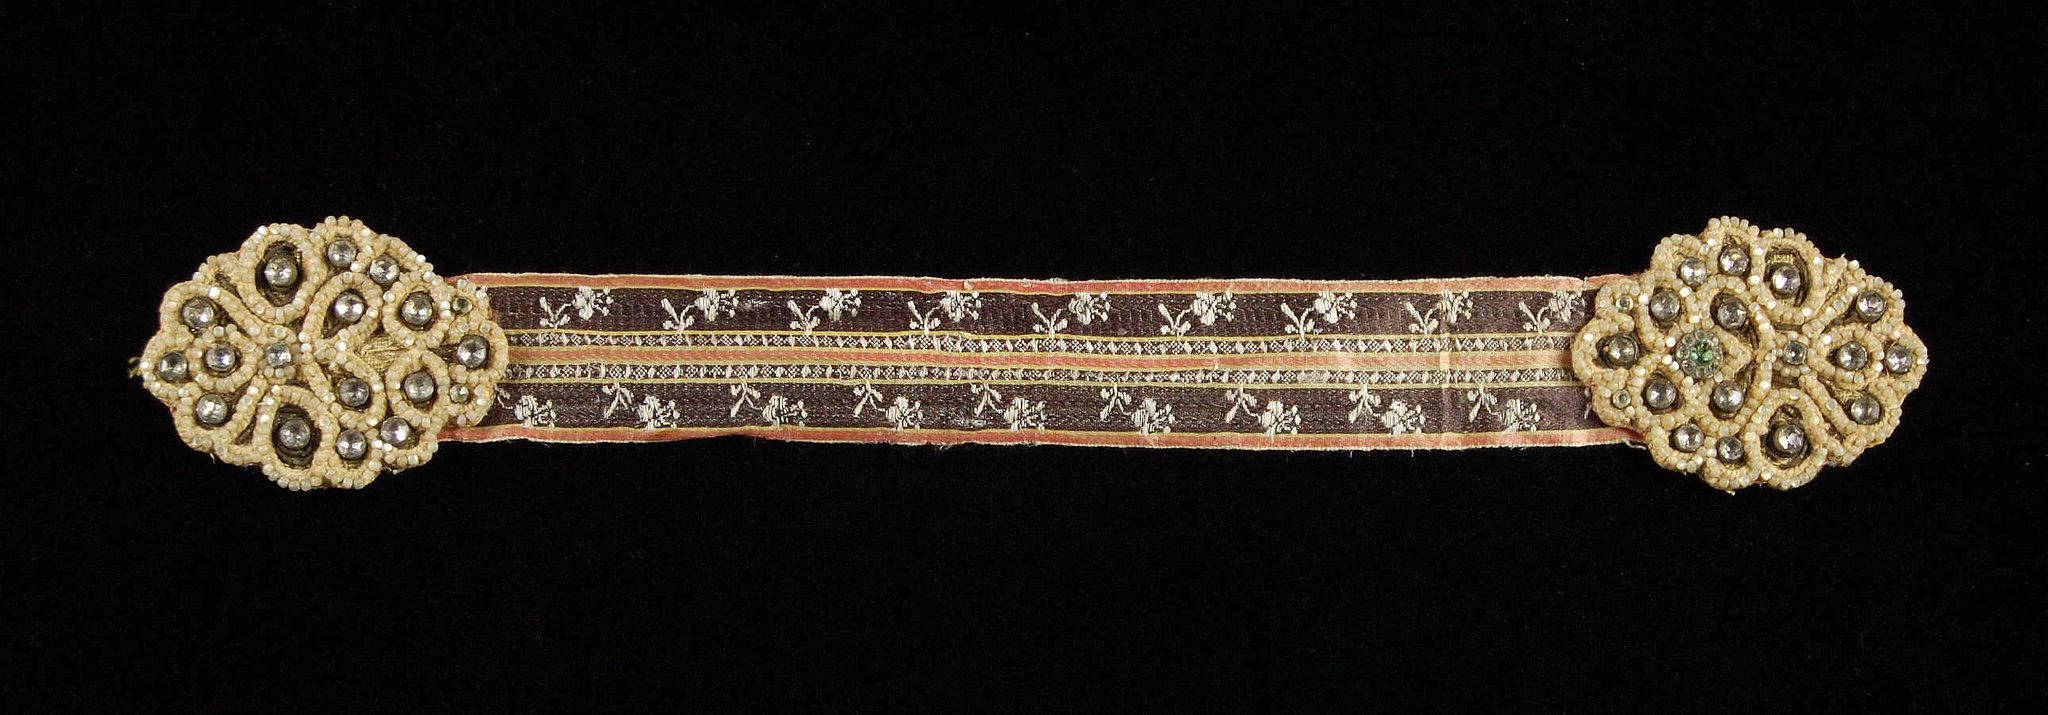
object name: ornament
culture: russian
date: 1801-1900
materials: cotton, glass, shell, silk